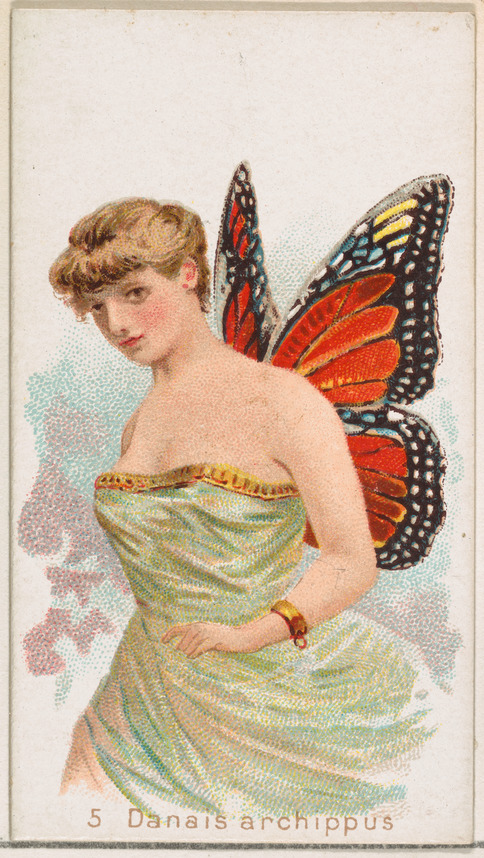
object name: print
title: Card 5, Danais Archippus, from the Butterflies series (N183) issued by Wm. S. Kimball & Co.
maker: william s. kimball & company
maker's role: publisher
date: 1888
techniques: color lithograph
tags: women,butterflies